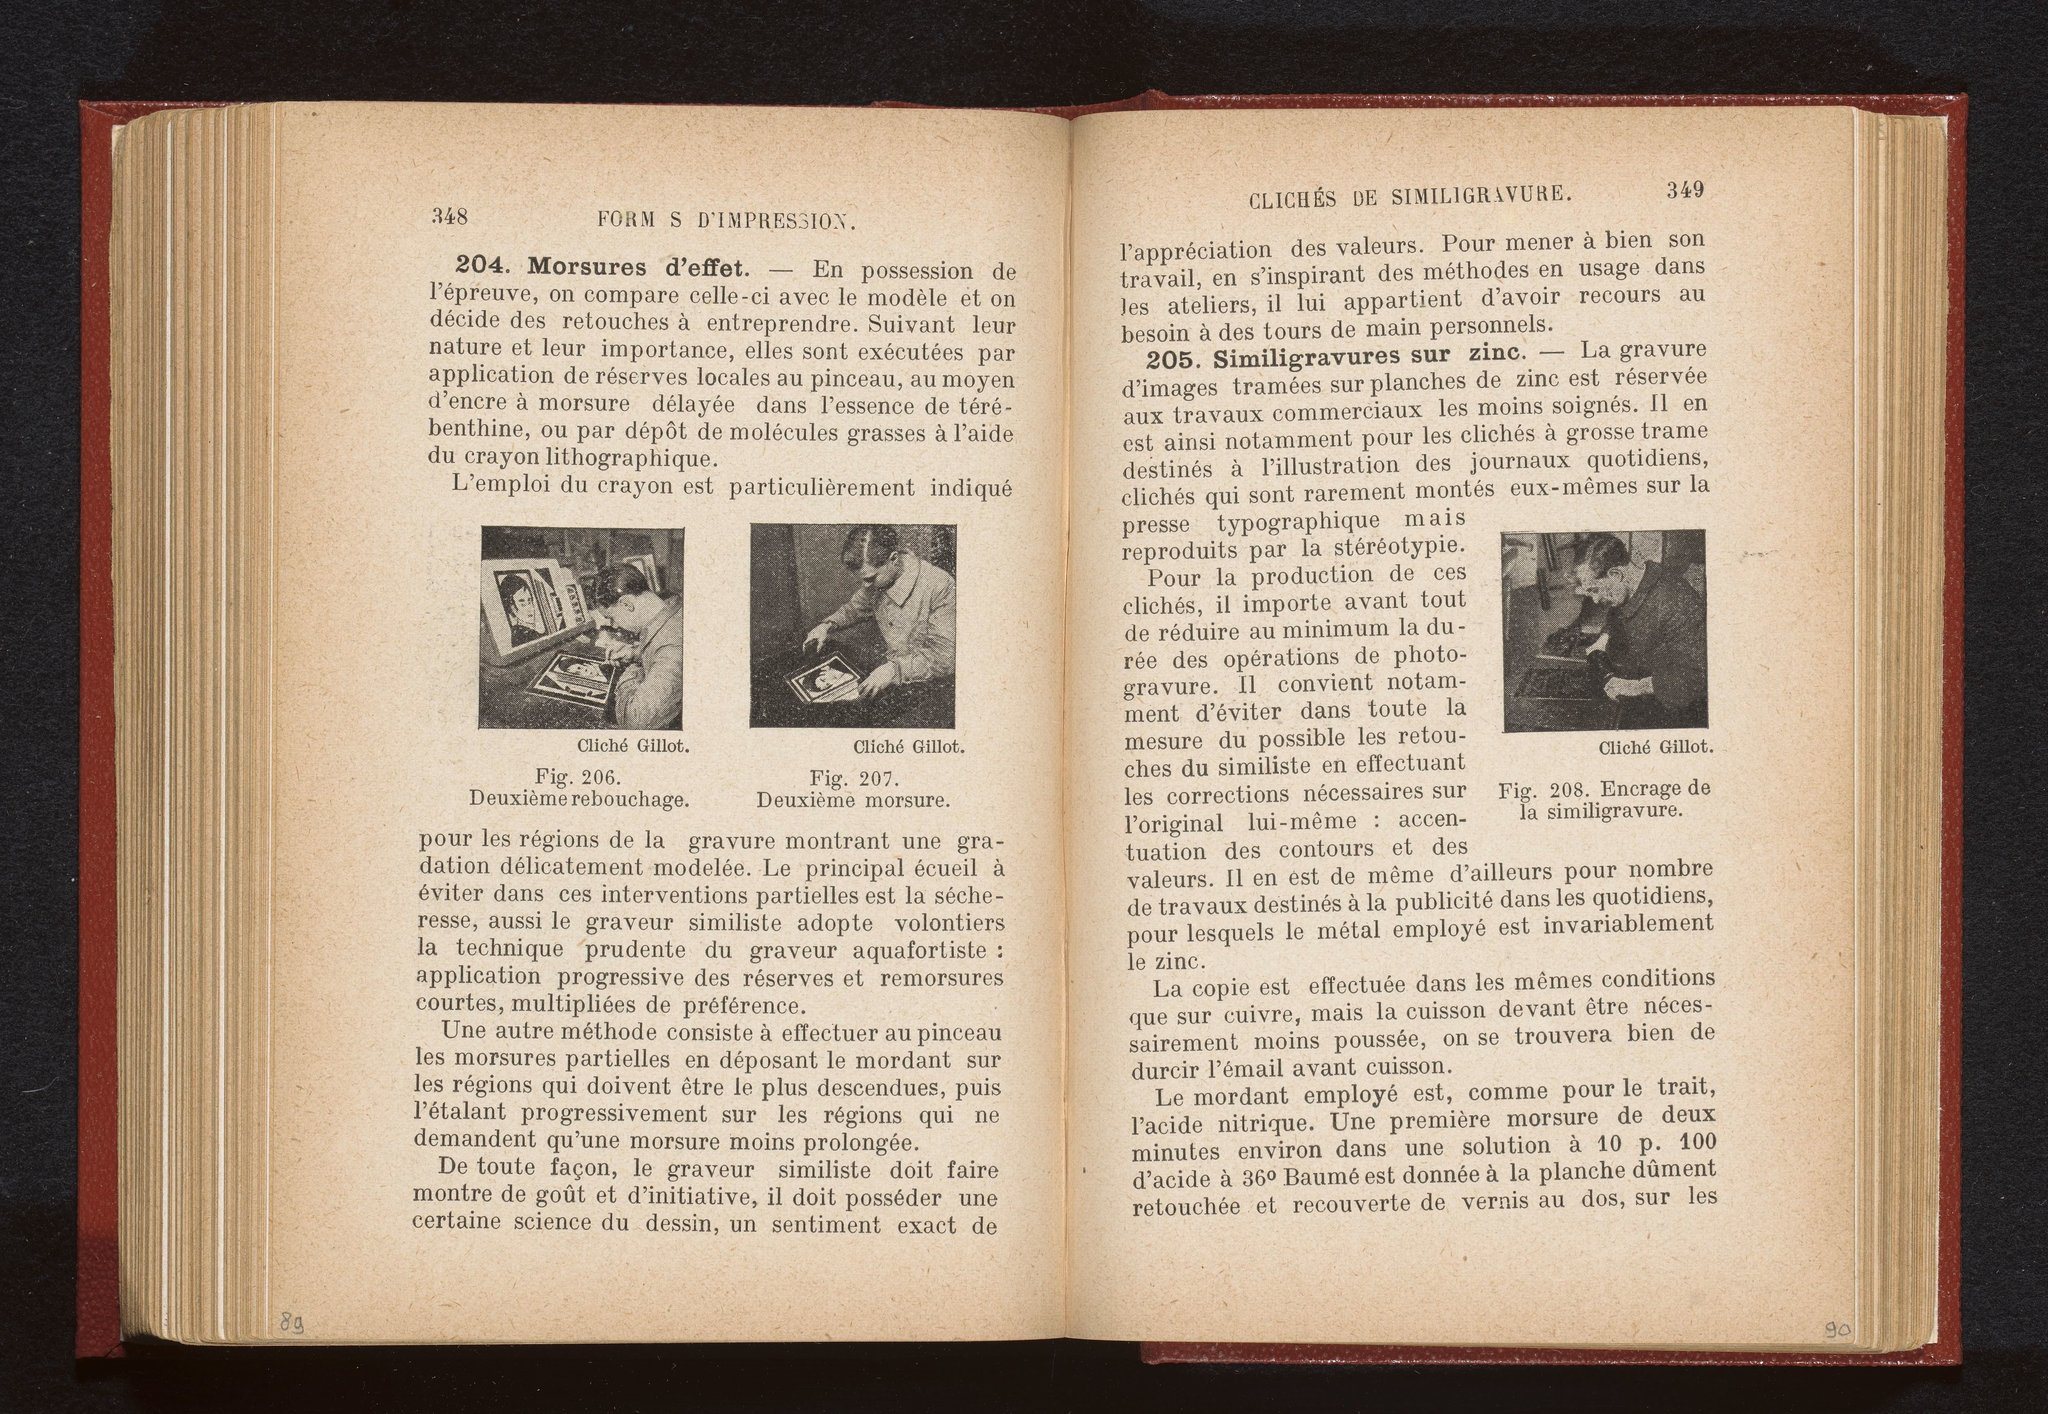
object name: photomechanical print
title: Man die een plaat voorbereidt voor vermoedelijk een autotypie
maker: Anonymous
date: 1922-1932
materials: paper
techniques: autotype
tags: print, e.g.: engraving, etching, lithograph, photographic apparatus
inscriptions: number: ‘Fig. 206. Fig. 207.’